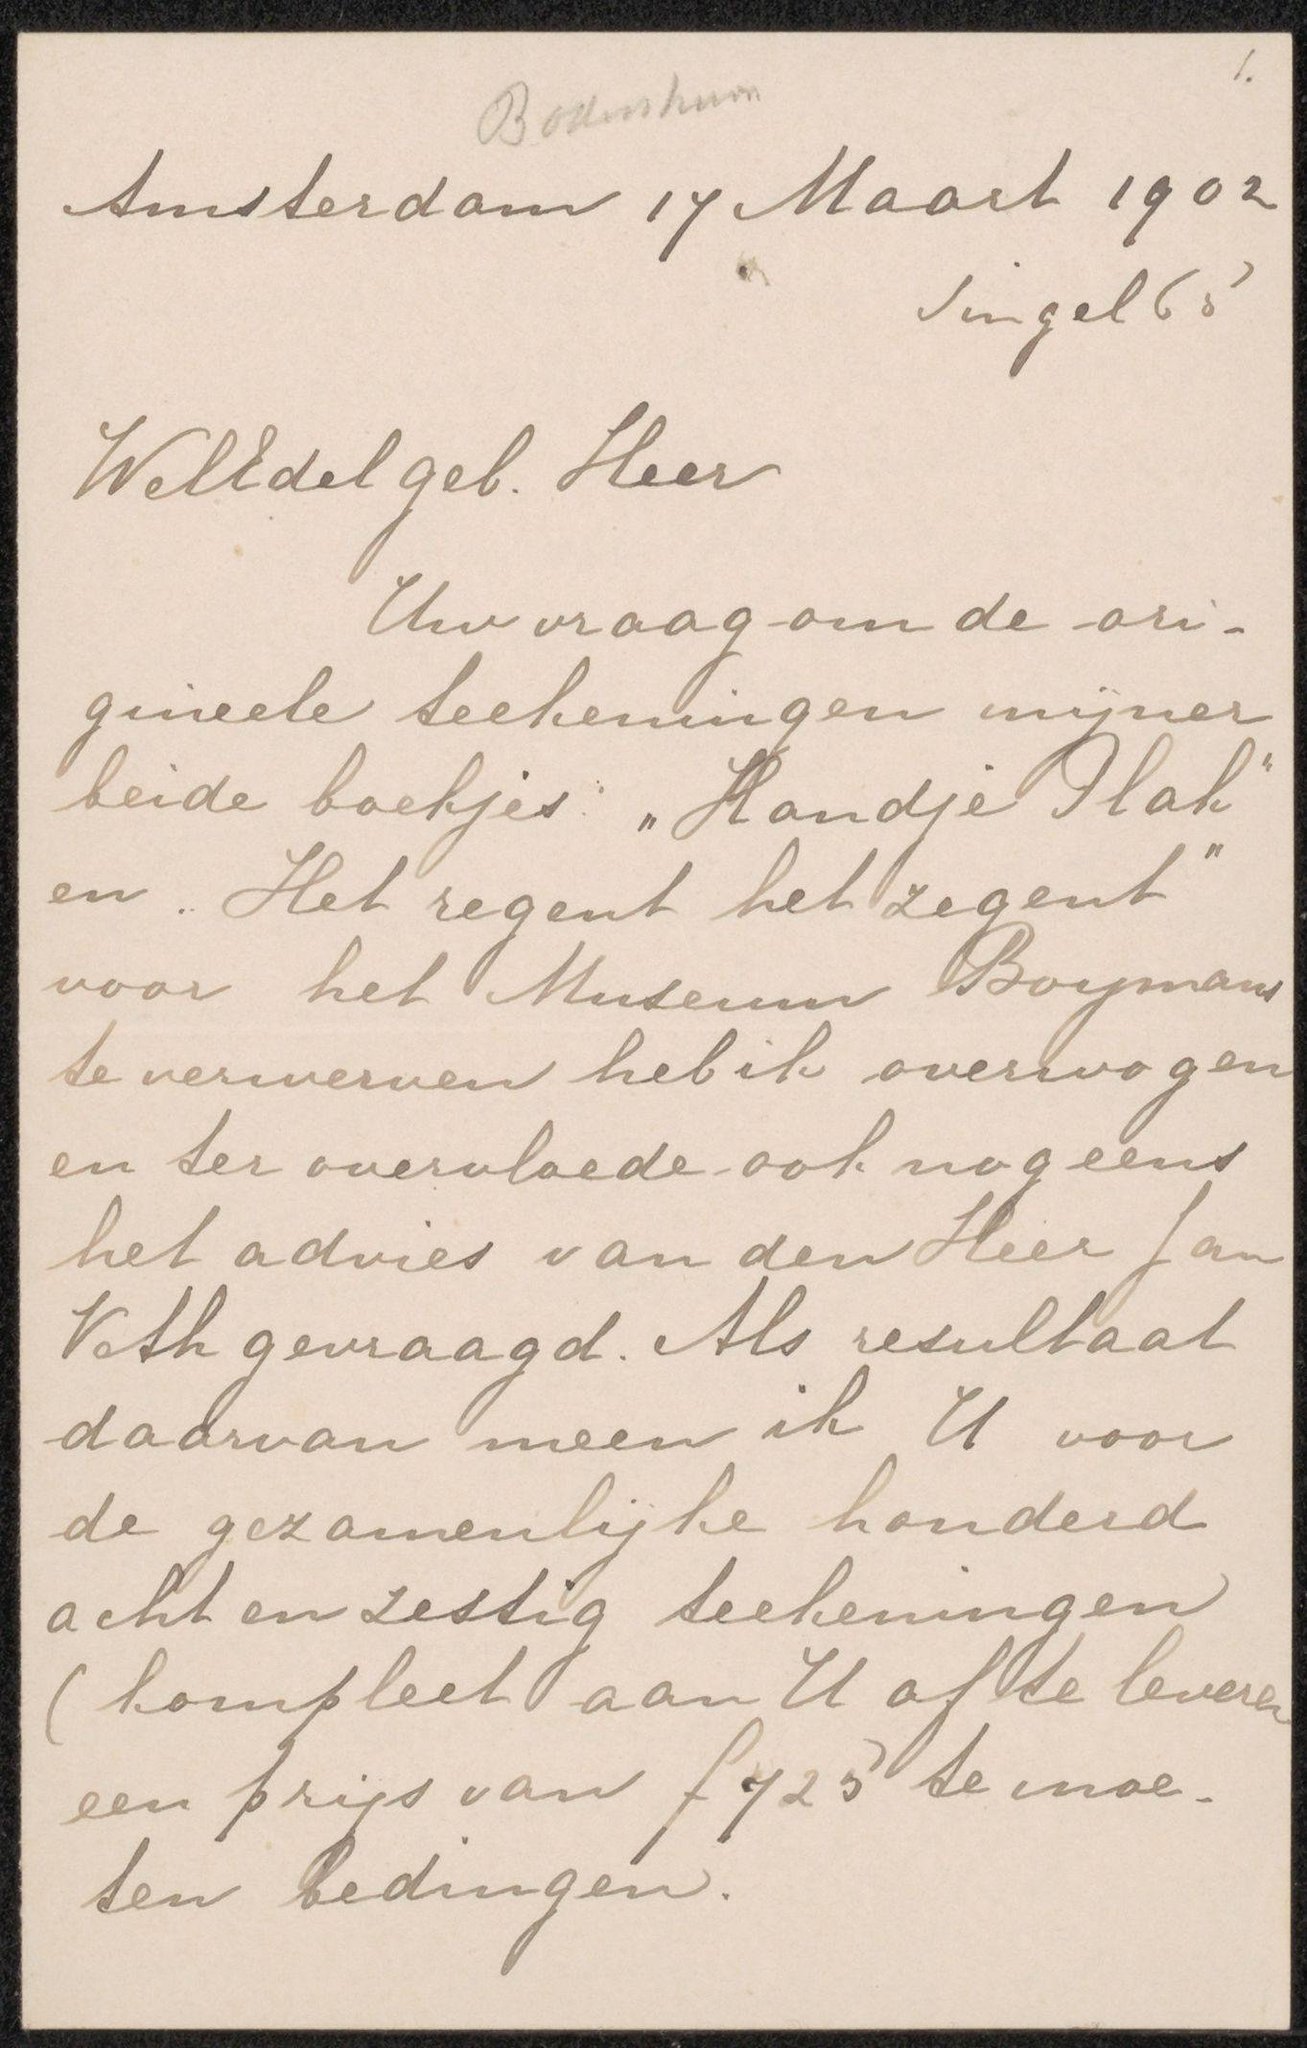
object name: letter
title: Brief aan Pieter Haverkorn van Rijsewijk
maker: nelly bodenheim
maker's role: designer, draughtsman, print maker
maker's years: 1874-1951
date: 1902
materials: ink, paper, pencil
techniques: pen, writing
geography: amsterdam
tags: painter, jan veth, pieter haverkorn van rijsewijk, drawing, illustration ~ printed matter, book, art collecting, money, printed matter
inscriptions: collector's mark: ‘RPK’